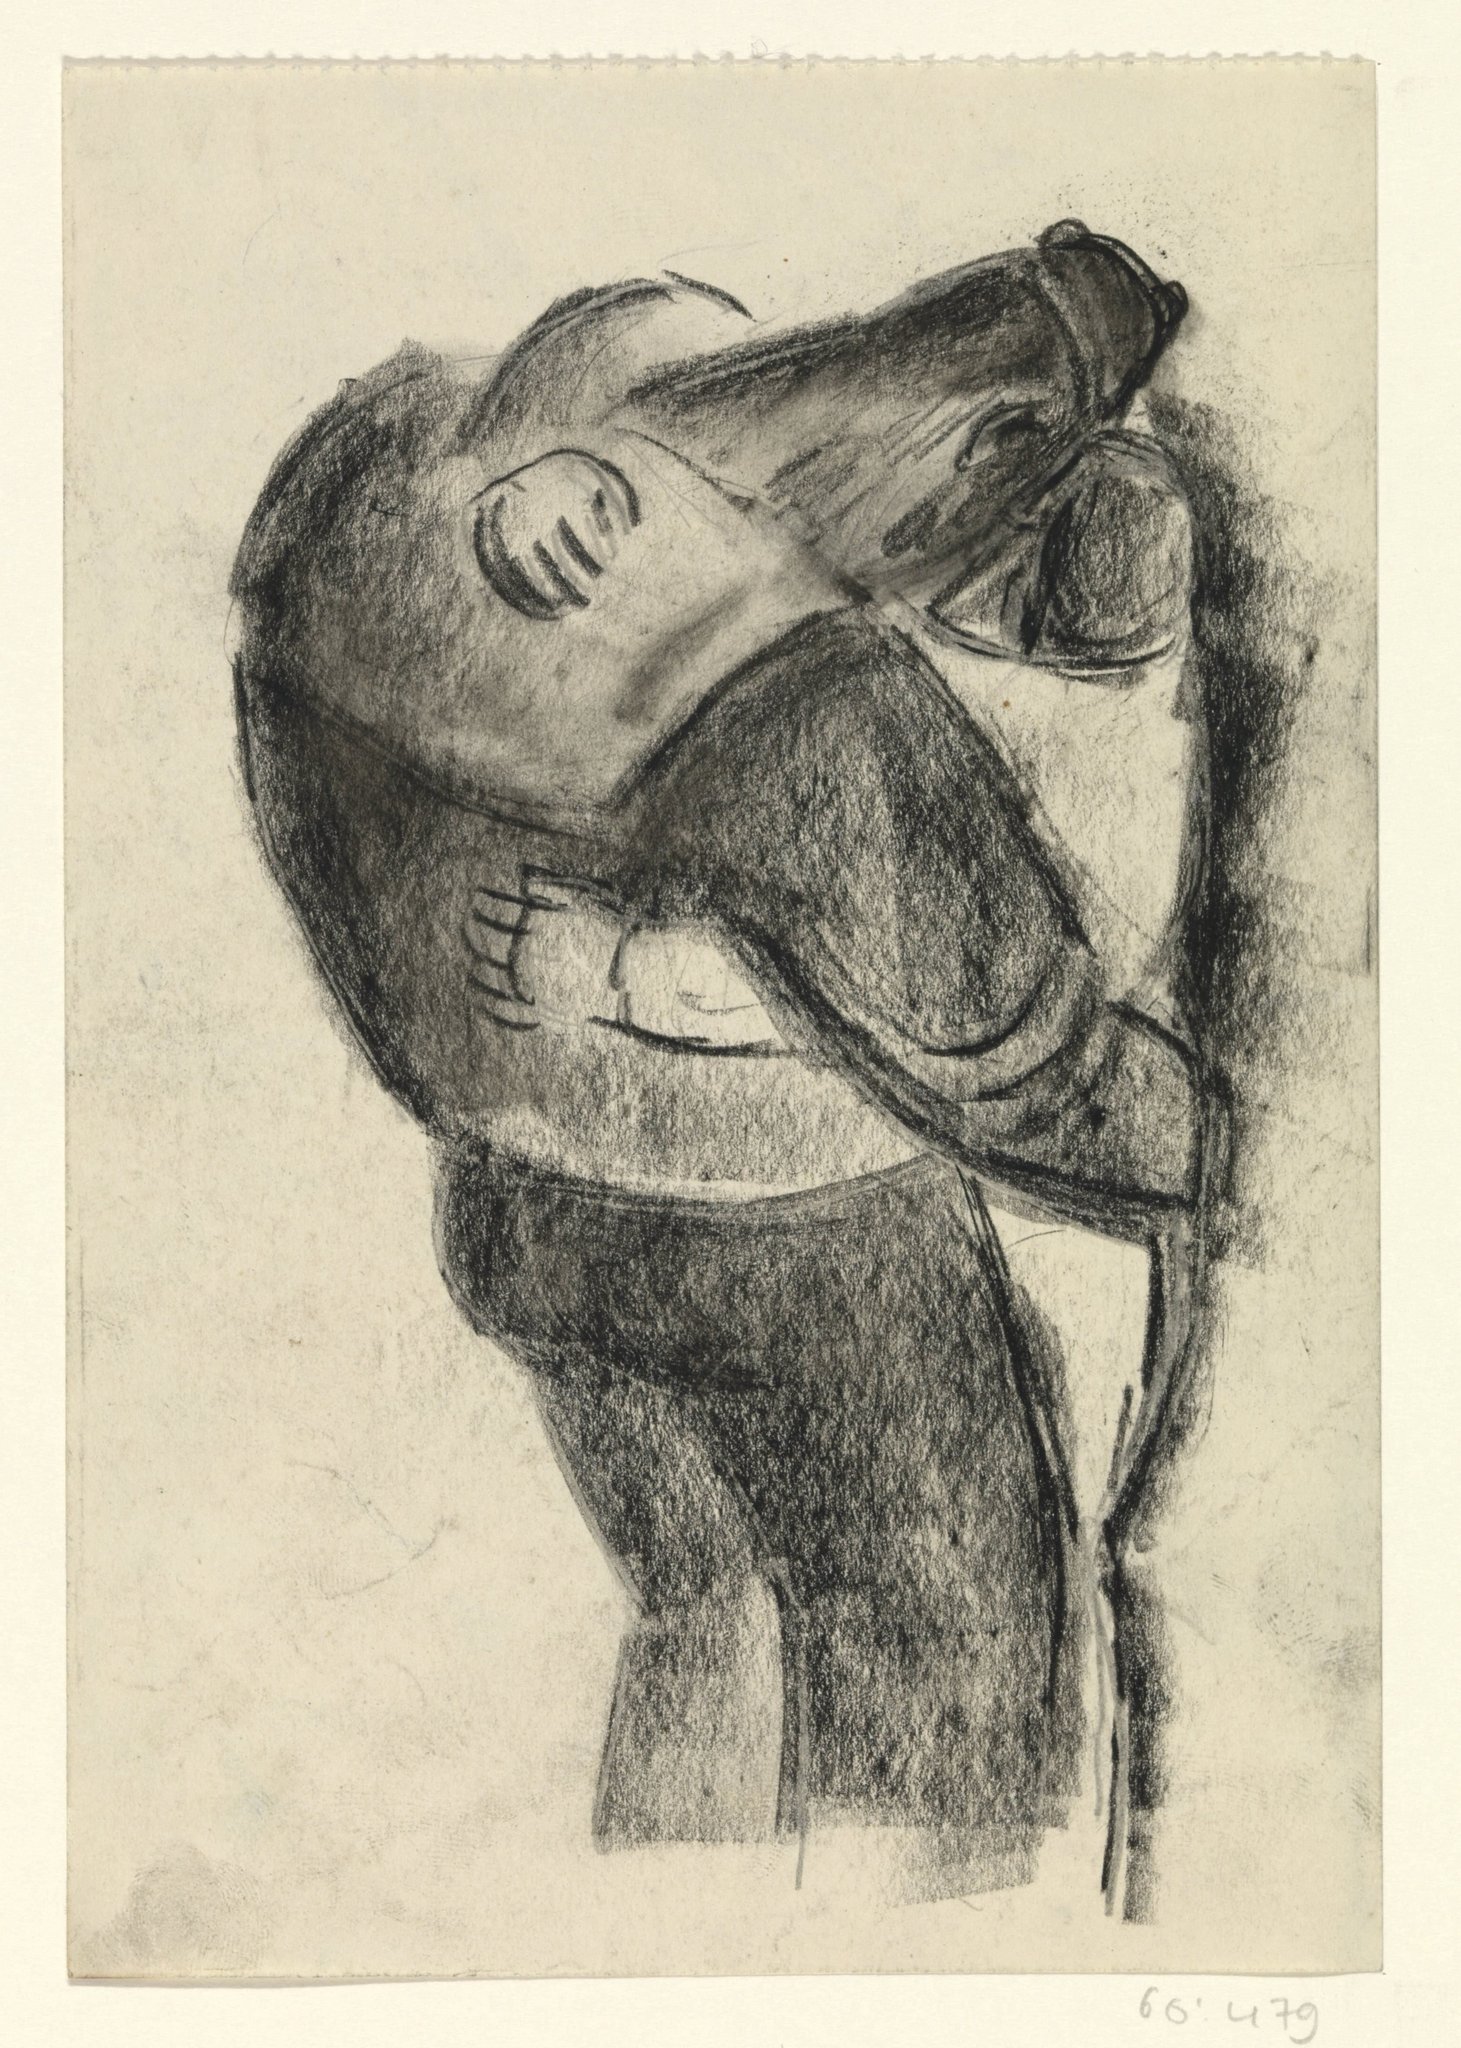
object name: drawing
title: Omhelzend koppel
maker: leo gestel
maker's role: draughtsman, print maker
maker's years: 1881-1941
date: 1891-1941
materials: charcoal, paper, pencil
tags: embracing each other, kissing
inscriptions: collector's mark: Lugt 2228